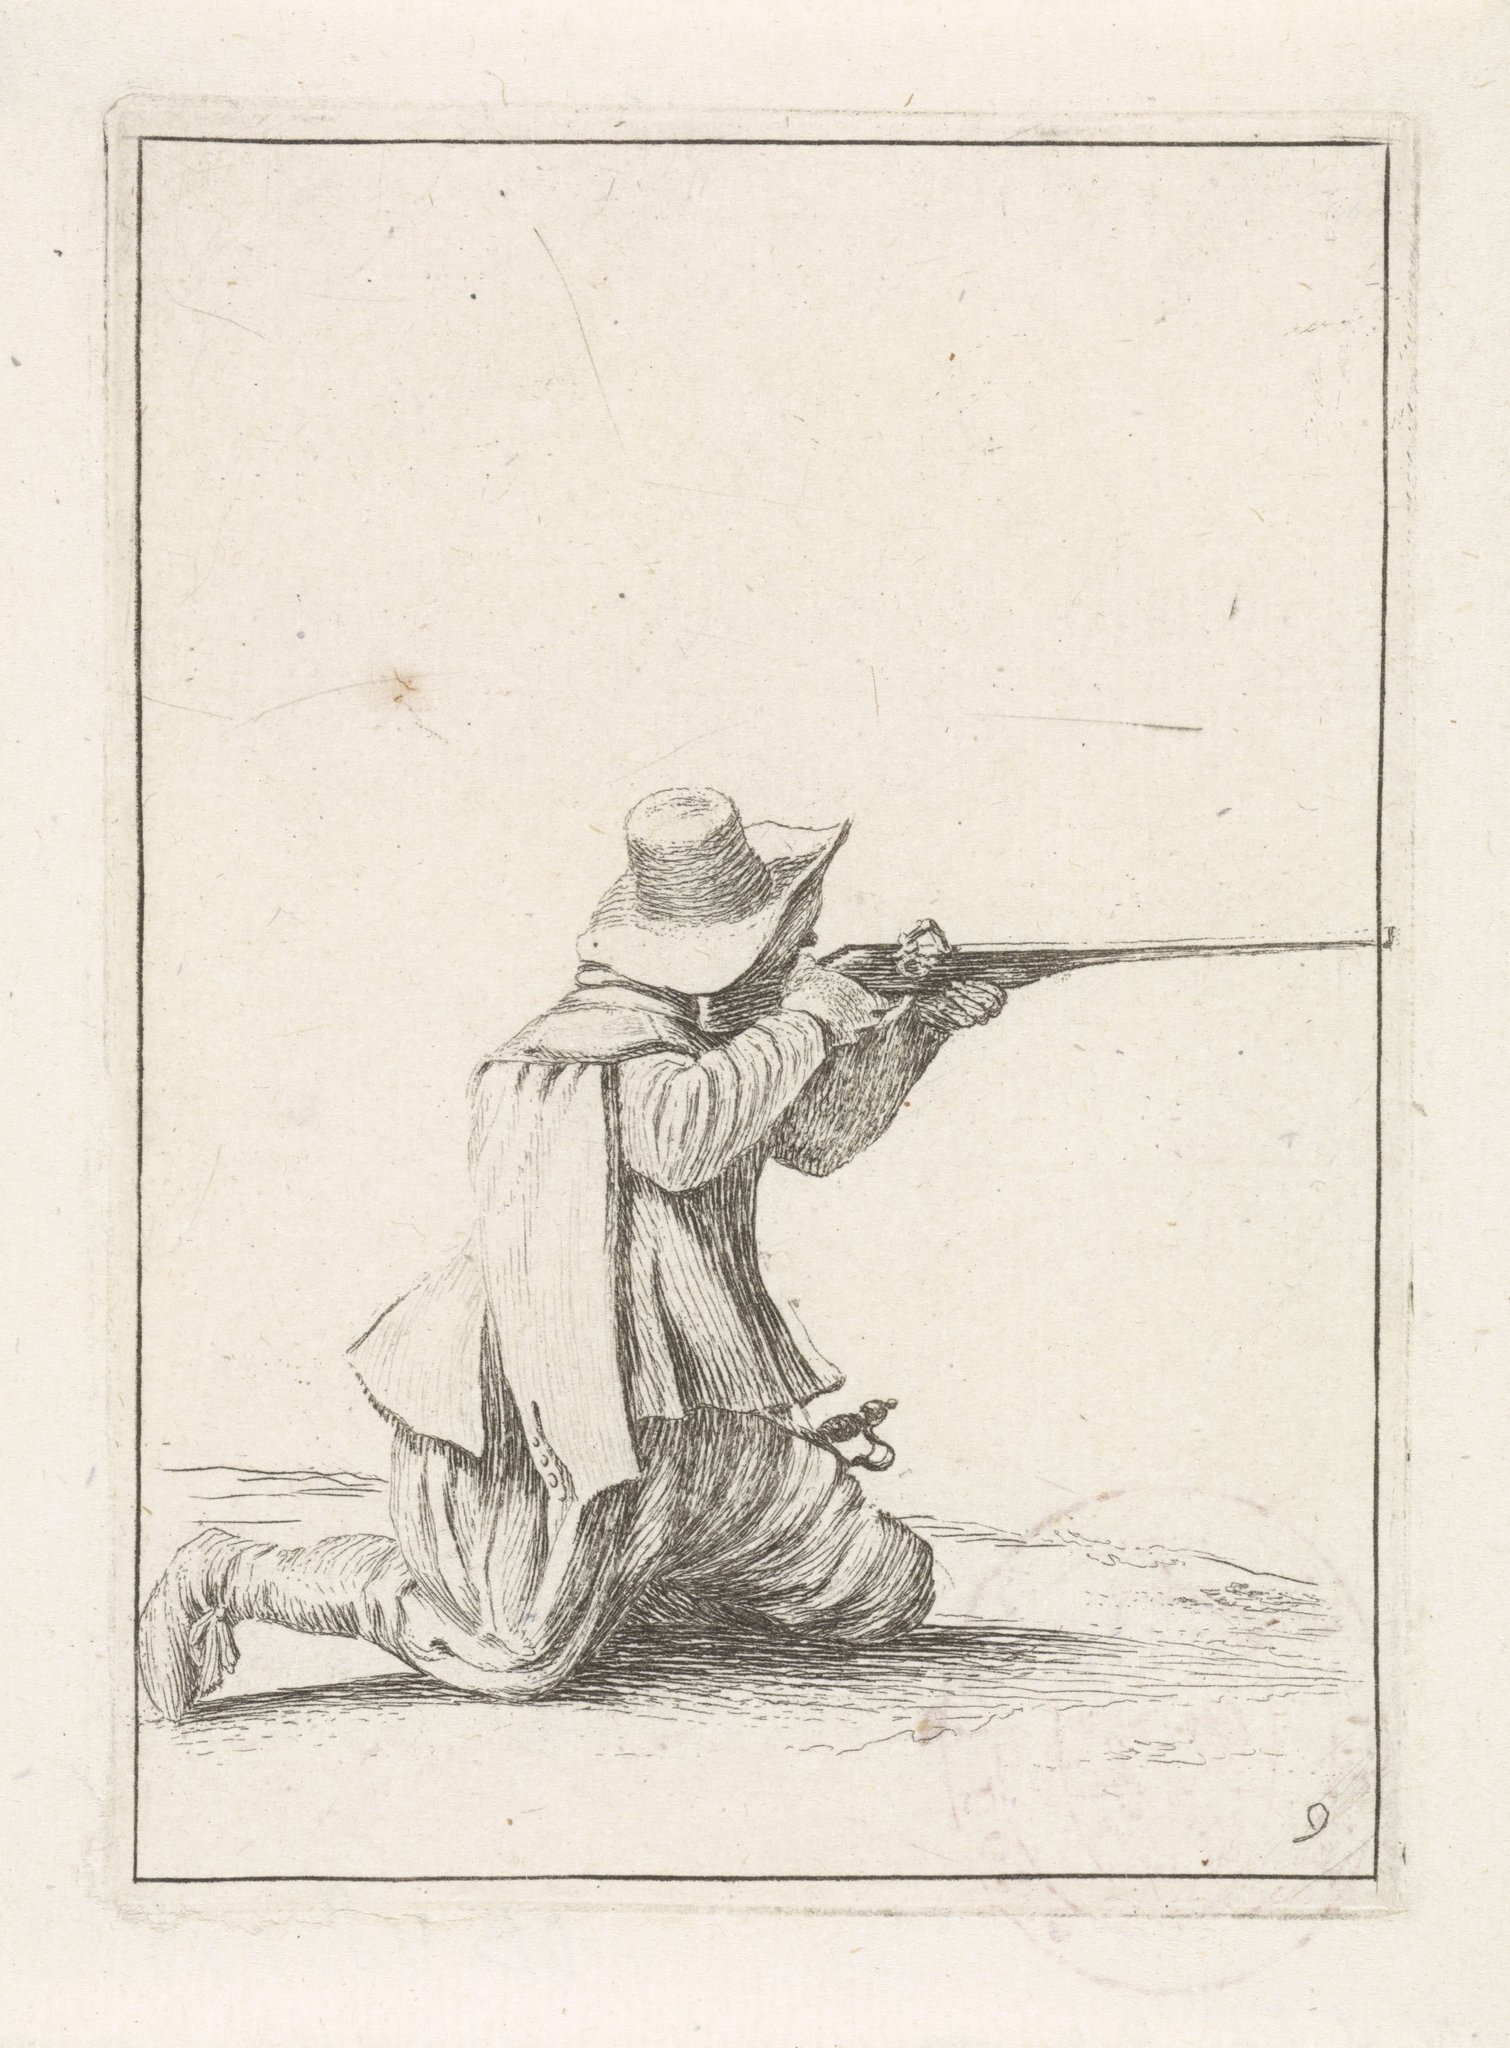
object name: print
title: Soldats & Chevaux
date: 1710-1717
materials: paper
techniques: etching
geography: amsterdam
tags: the soldier; the soldier's life (+ weapons), artillery range, firing range, shooting range ~ military training (+ weapons), kneeling on both knees (+ sideview, profile), handling of weapons ~ military training, firearms: rifle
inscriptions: collector's mark: Lugt 240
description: Geknielde soldaat naar rechts, zijn geweer aanleggende. Negende prent uit een serie van twaalf prenten met voorstellingen van soldaten en paarden.